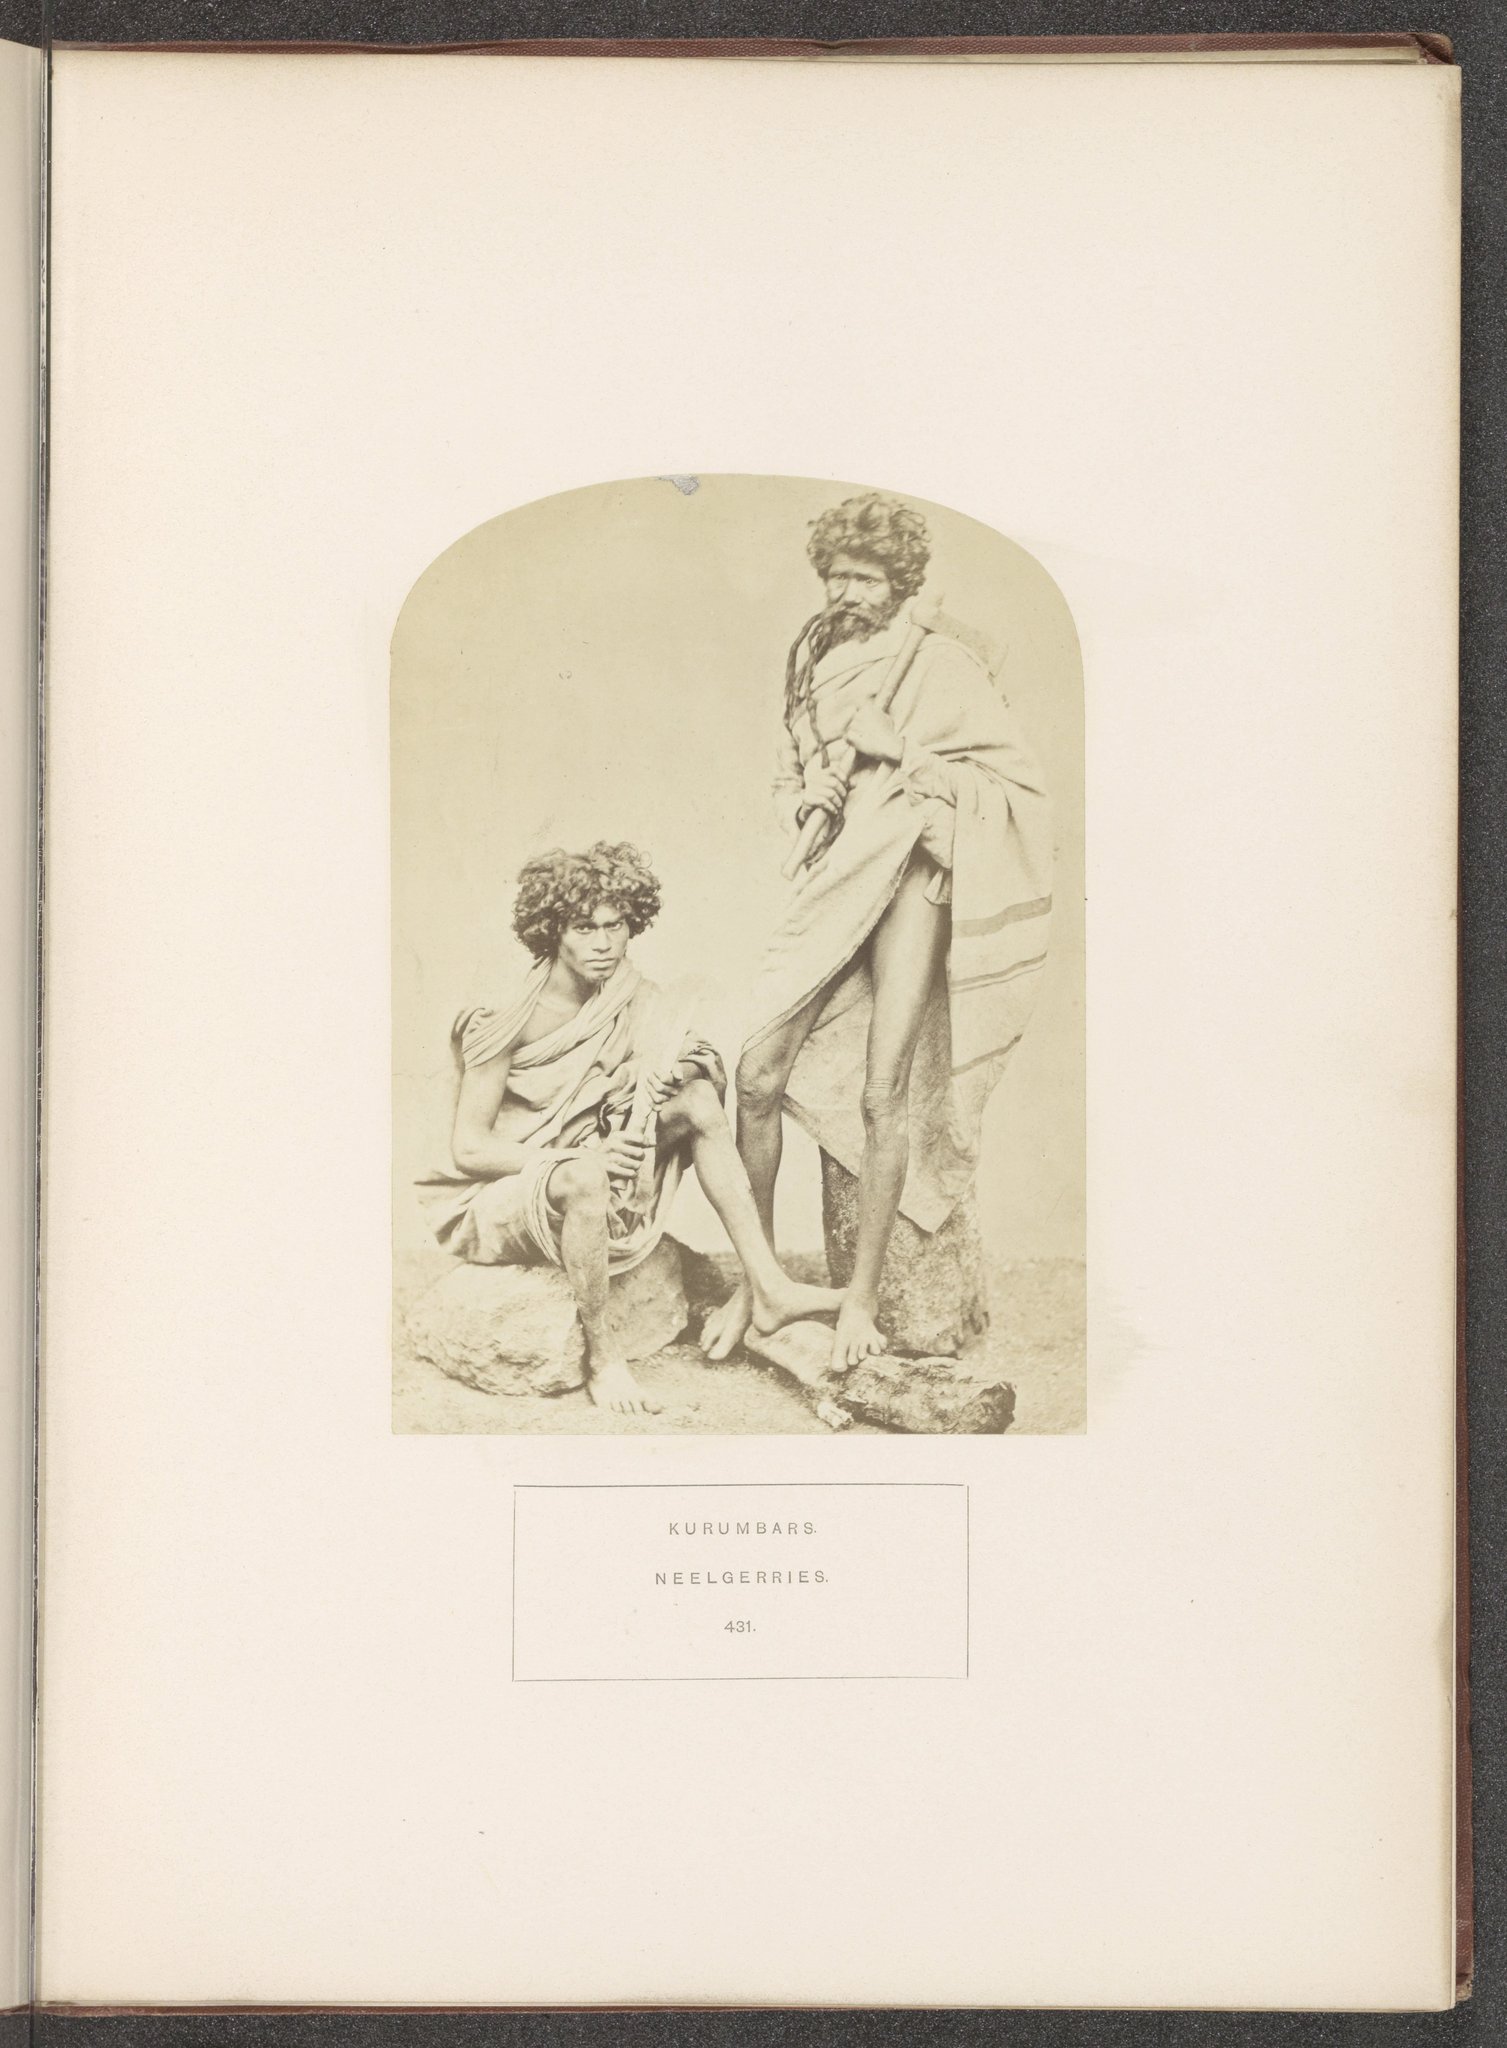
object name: photograph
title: Portrait of two unknown men from the Kurumba tribe of the Nilgiri mountains in Tamil Nadu, India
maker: Anonymous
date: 1865-1875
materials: photographic support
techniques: albumen print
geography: nilgiris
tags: human races; peoples; nationalities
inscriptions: number: ‘431.’, inscription: ‘KURUMBARS./ NEELGERRIES.’